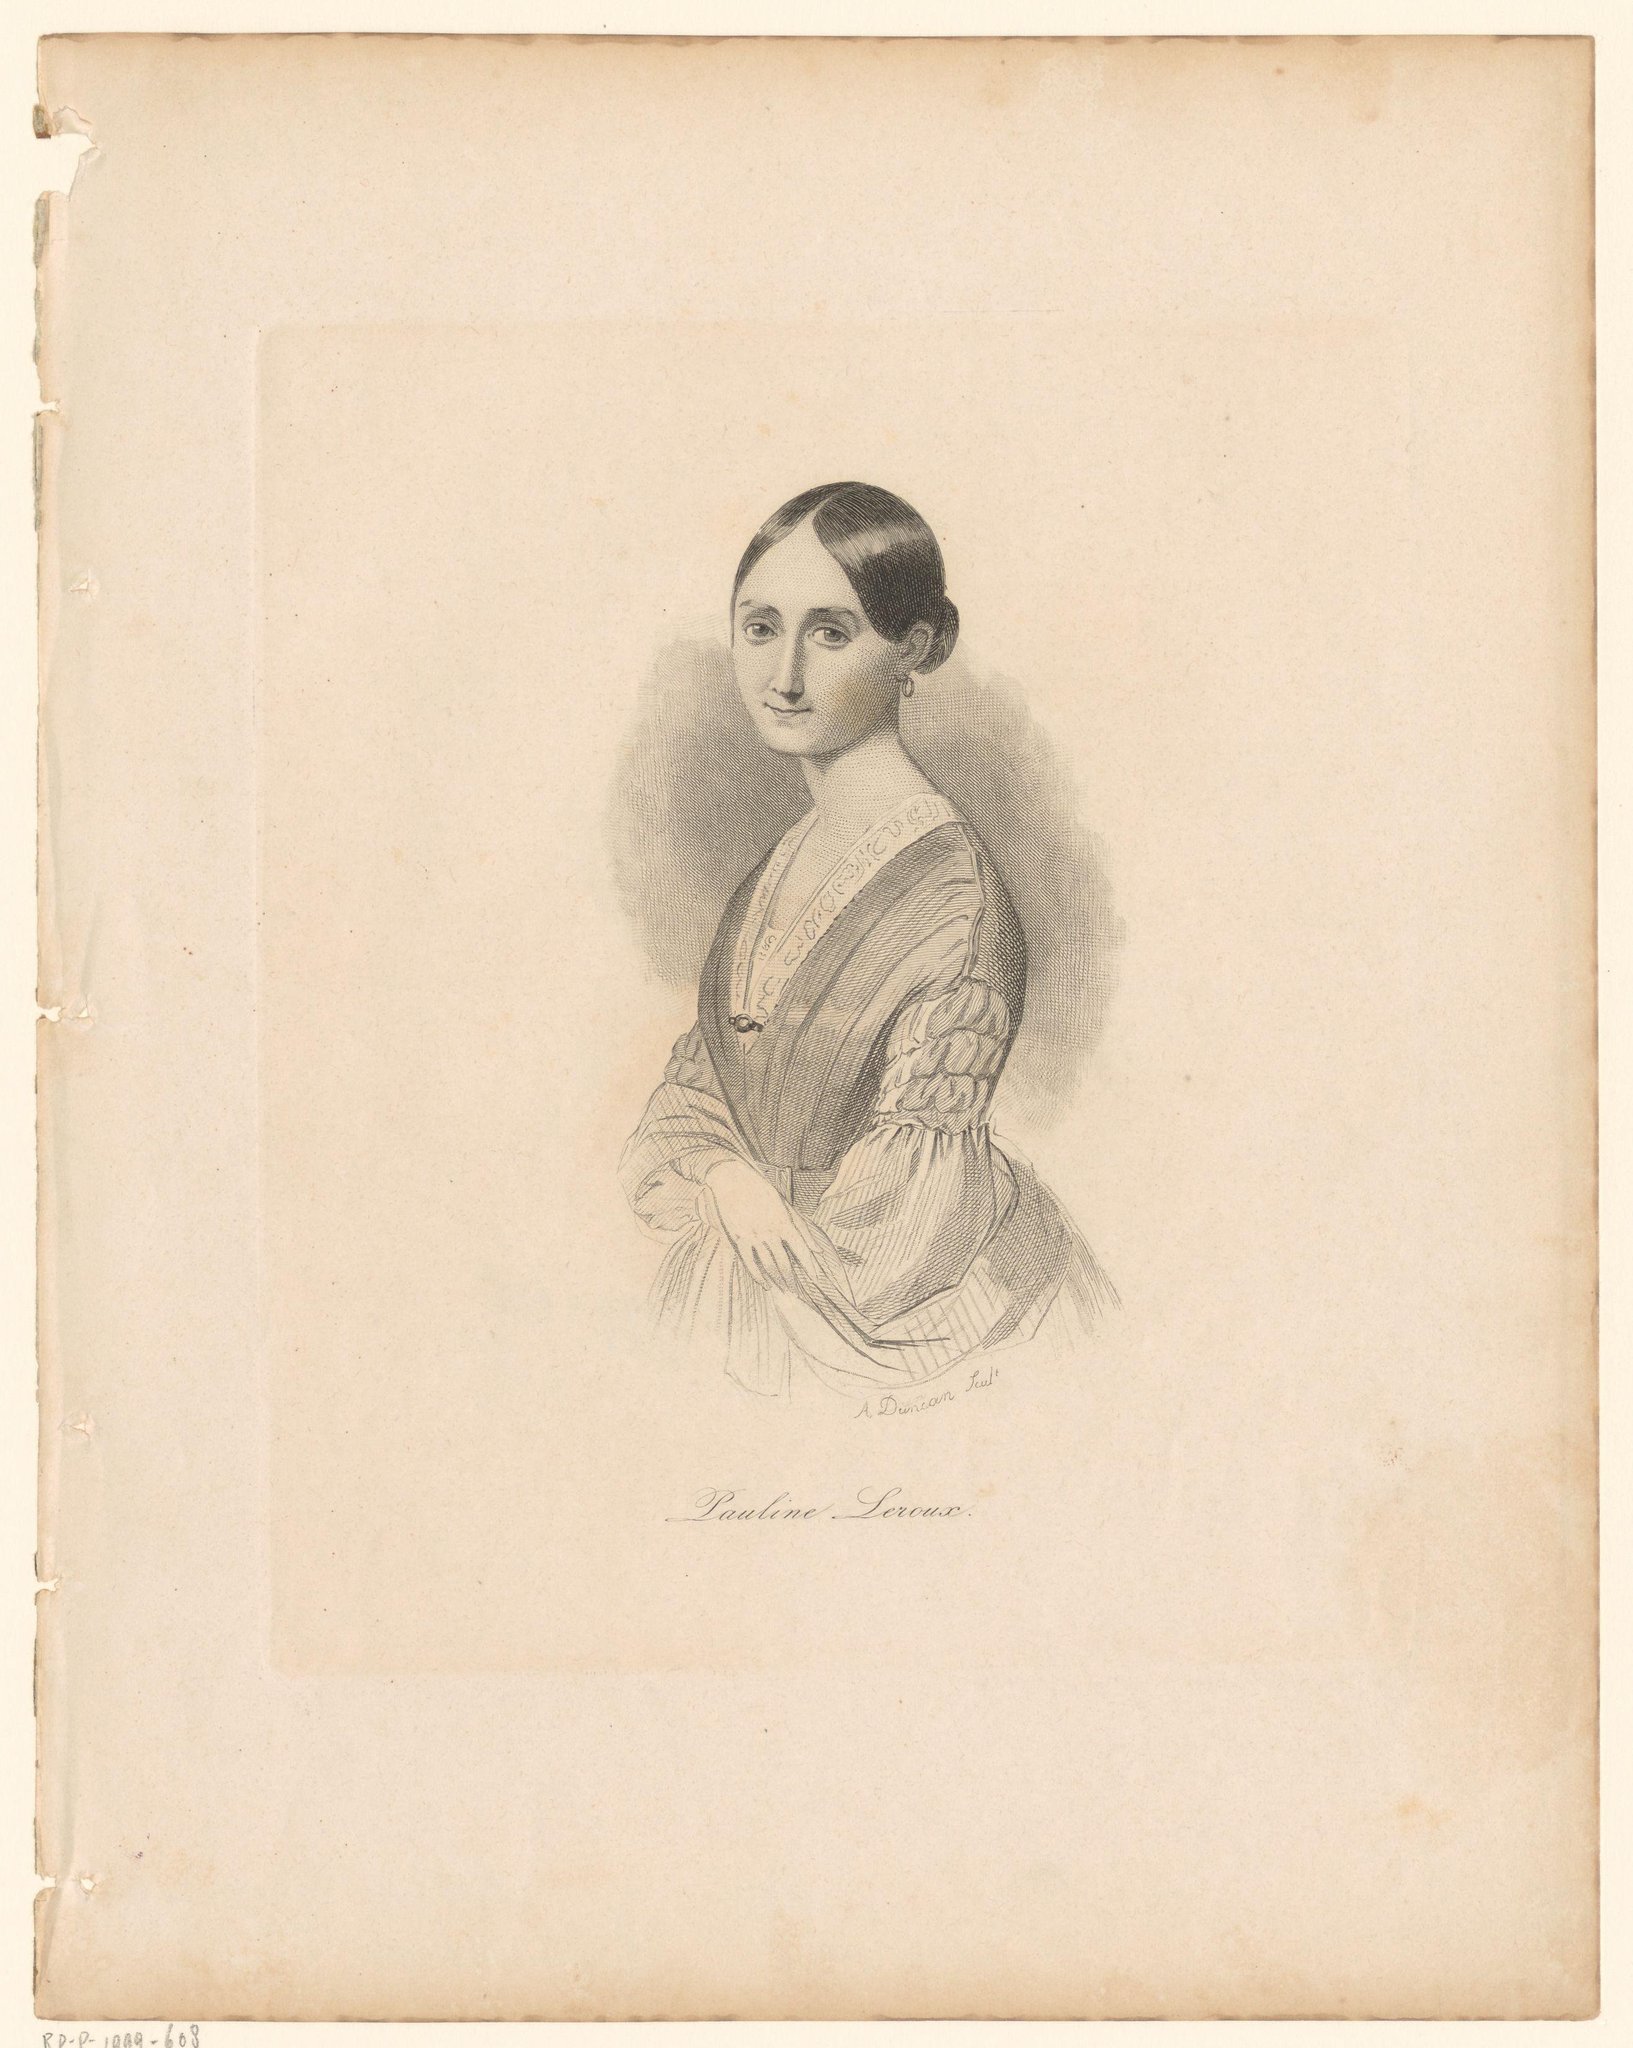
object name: print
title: Portret van Pauline Leroux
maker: andrew duncan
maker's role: print maker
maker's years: 1795-1855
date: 1827-1855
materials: paper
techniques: engraving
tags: historical persons, female dancer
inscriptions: collector's mark: Lugt 2228, collector's mark: Lugt 2760